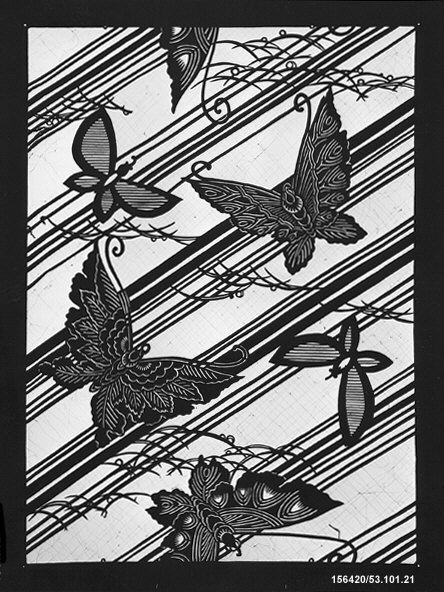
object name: stencil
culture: japanese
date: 1615-1868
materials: paper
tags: butterflies